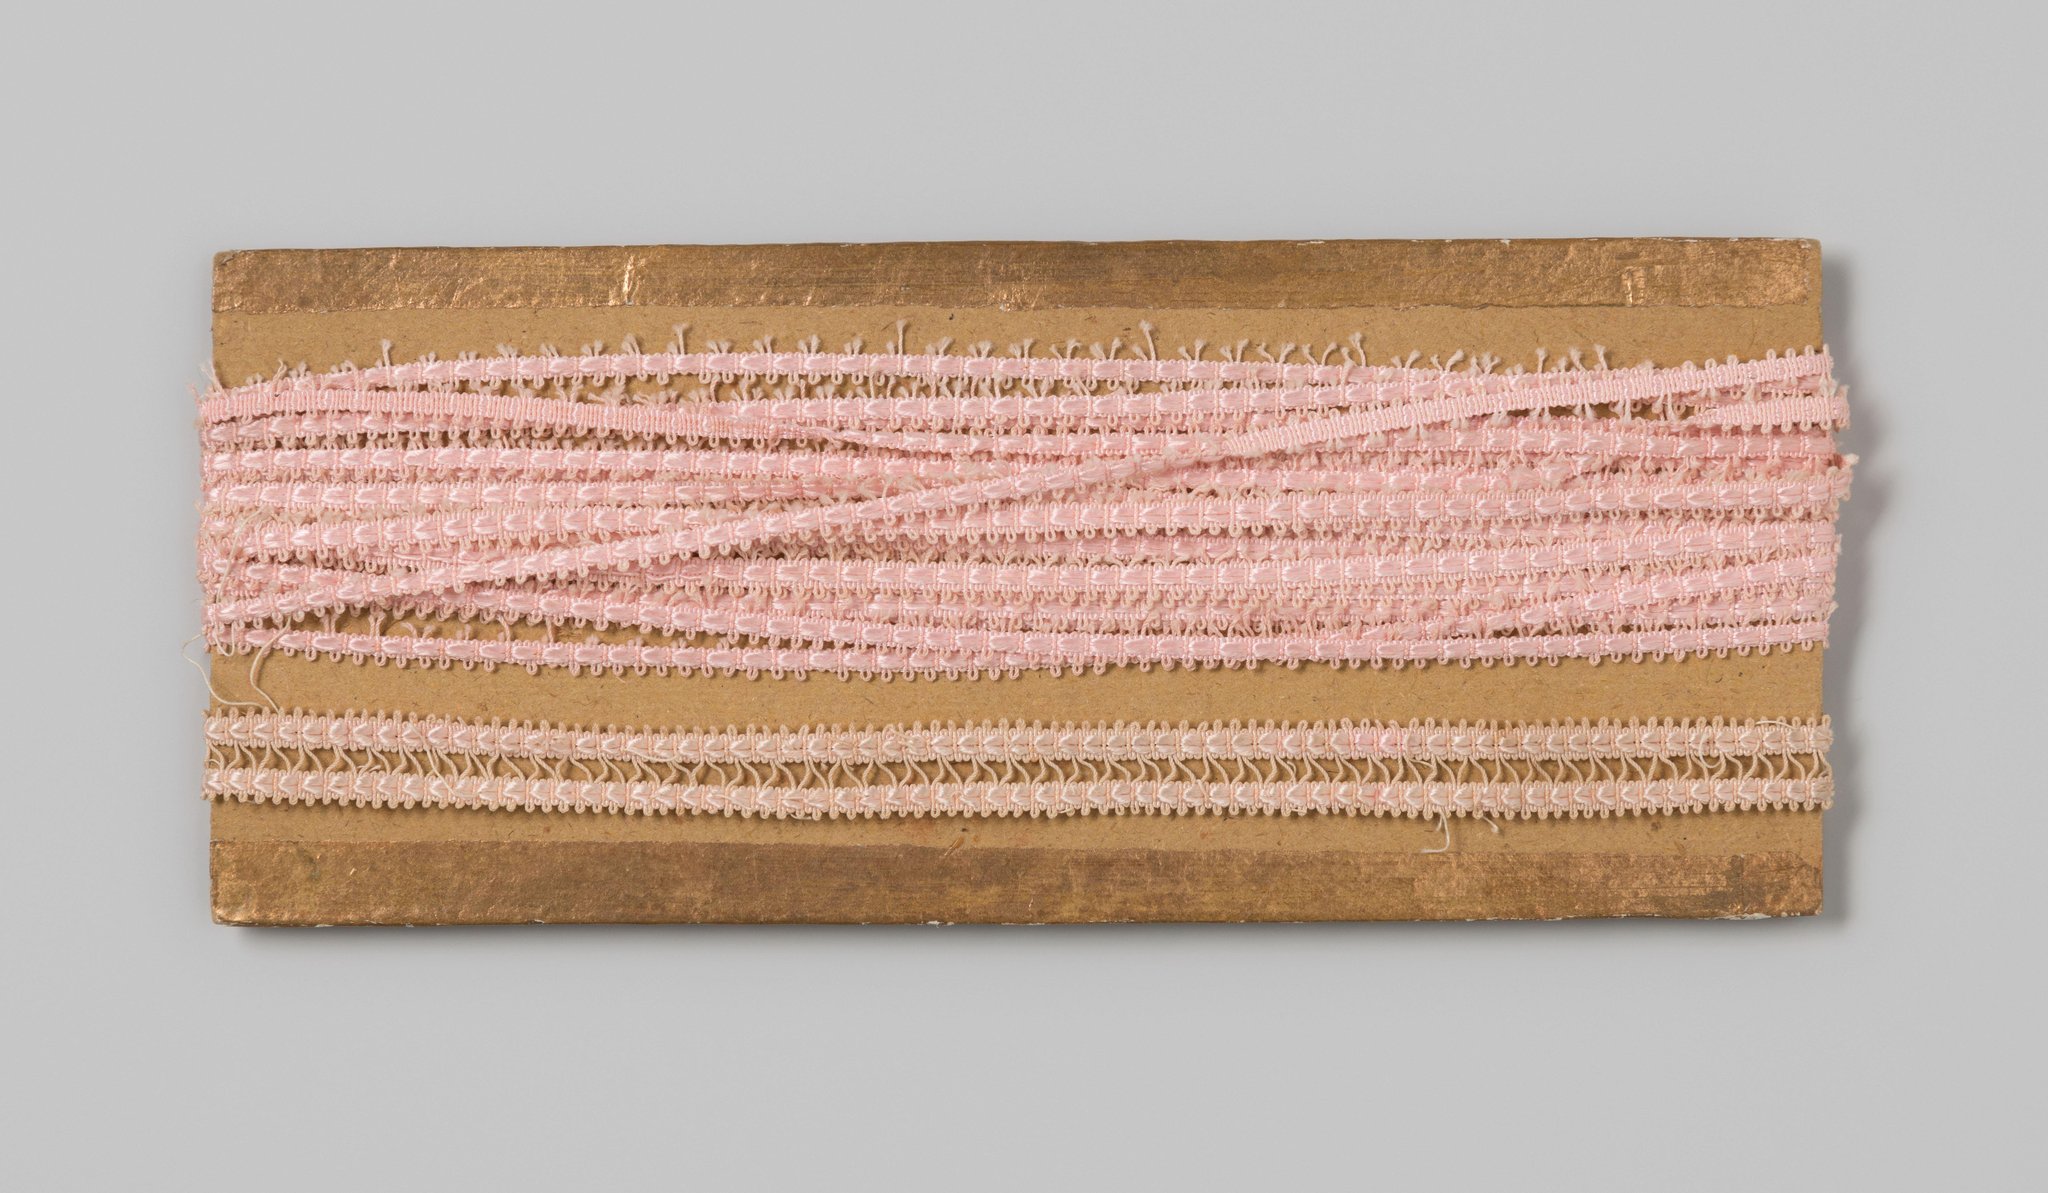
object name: braid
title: Passement lichtrose van kleur en voorzien van picots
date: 1920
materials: cardboard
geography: nijmegen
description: Passement lichtrose van kleur en voorzien van picots.